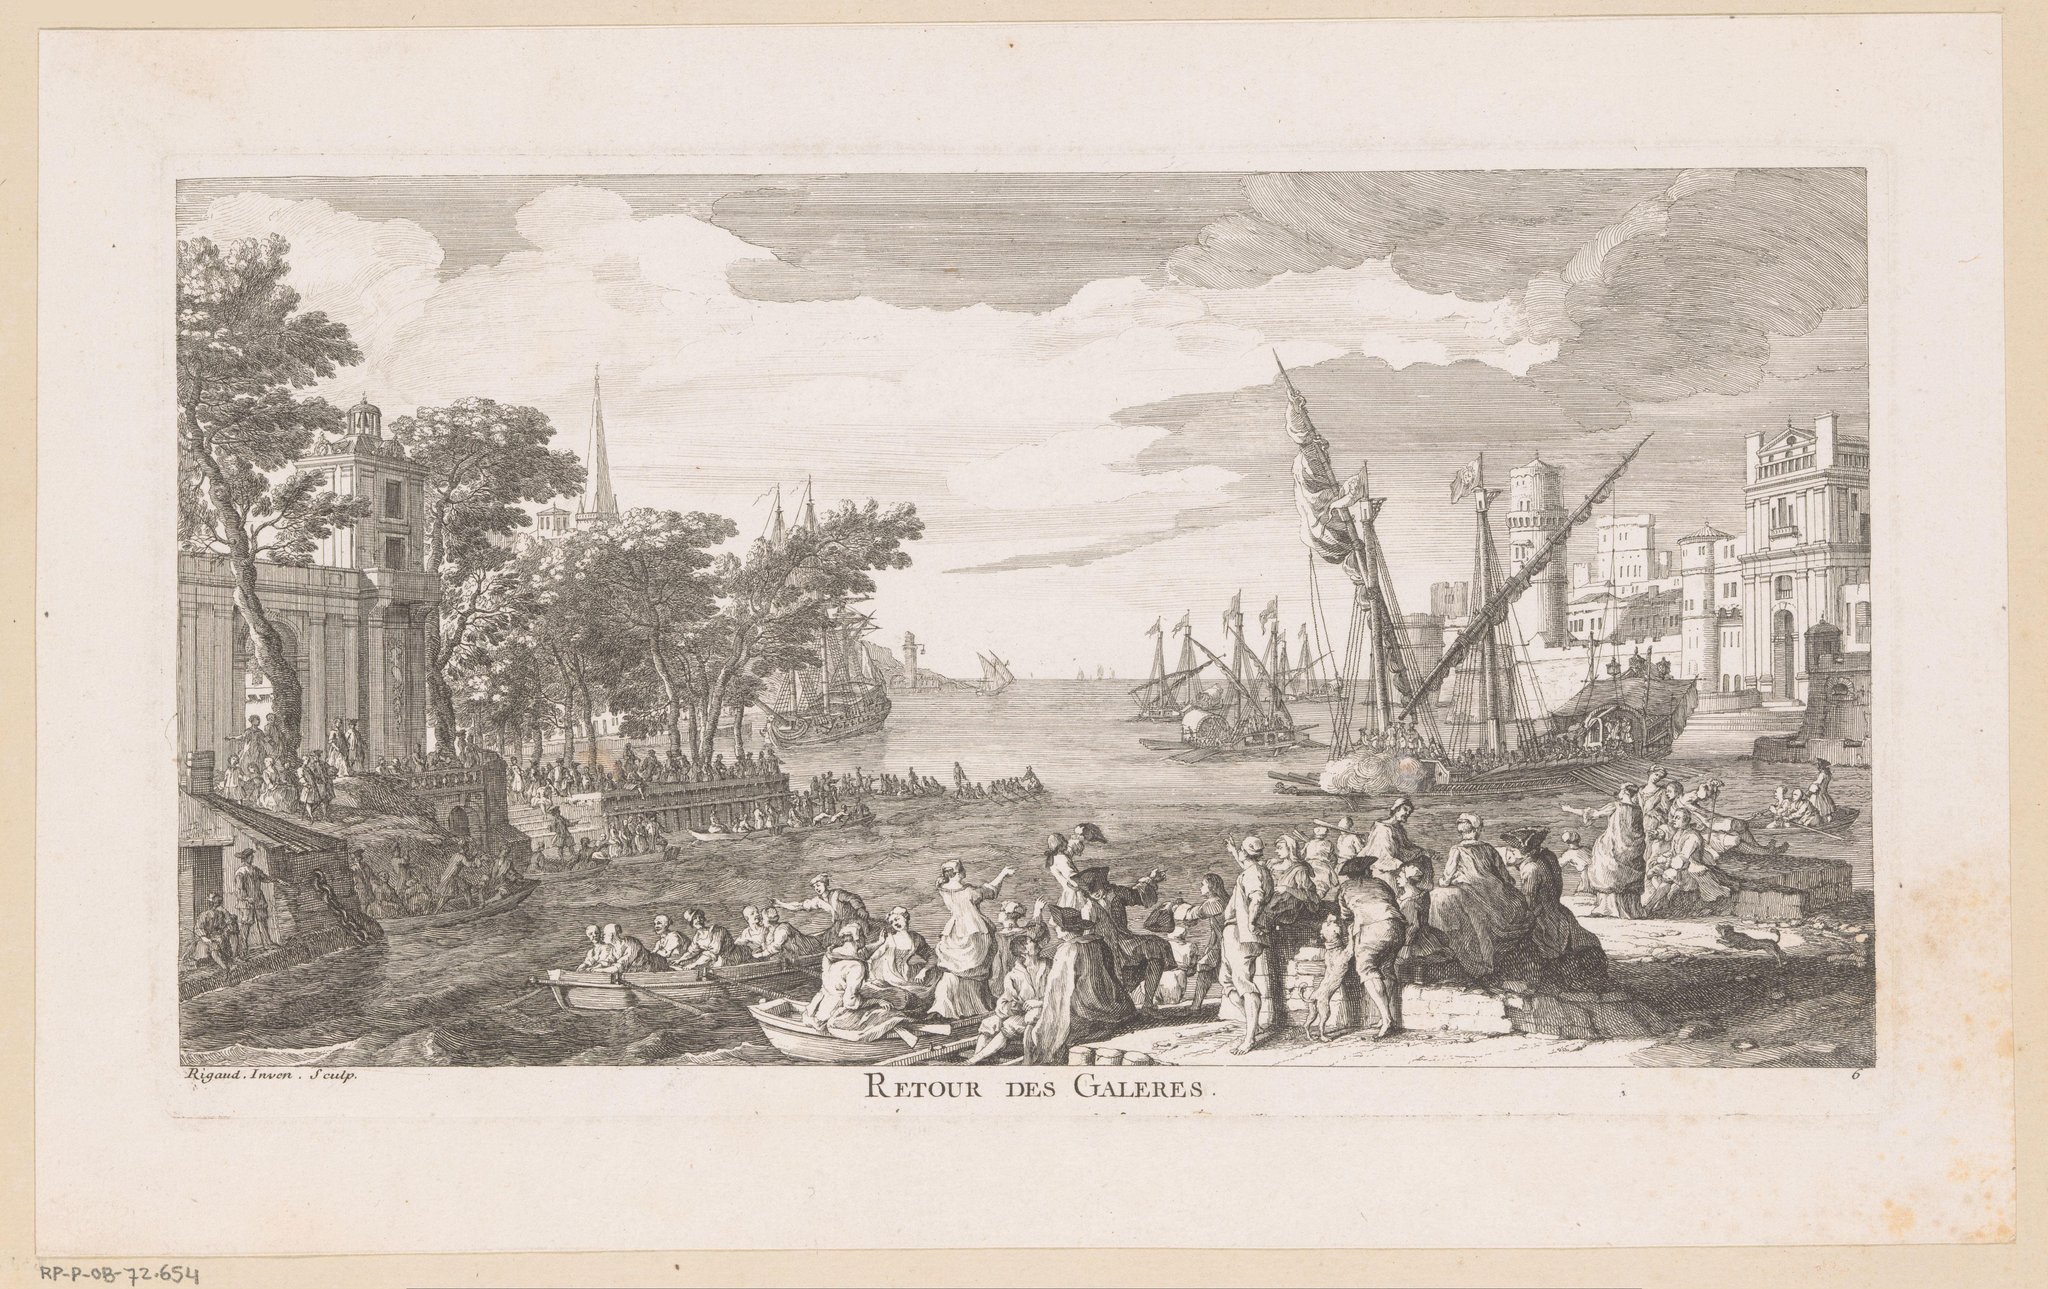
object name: print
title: Retour des Galeres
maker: jacques rigaud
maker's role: draughtsman, painter, print maker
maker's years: 1681-1754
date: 1720-1754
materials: paper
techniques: engraving, etching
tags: shipyard, shipdock, trireme, galley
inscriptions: collector's mark: Lugt 240